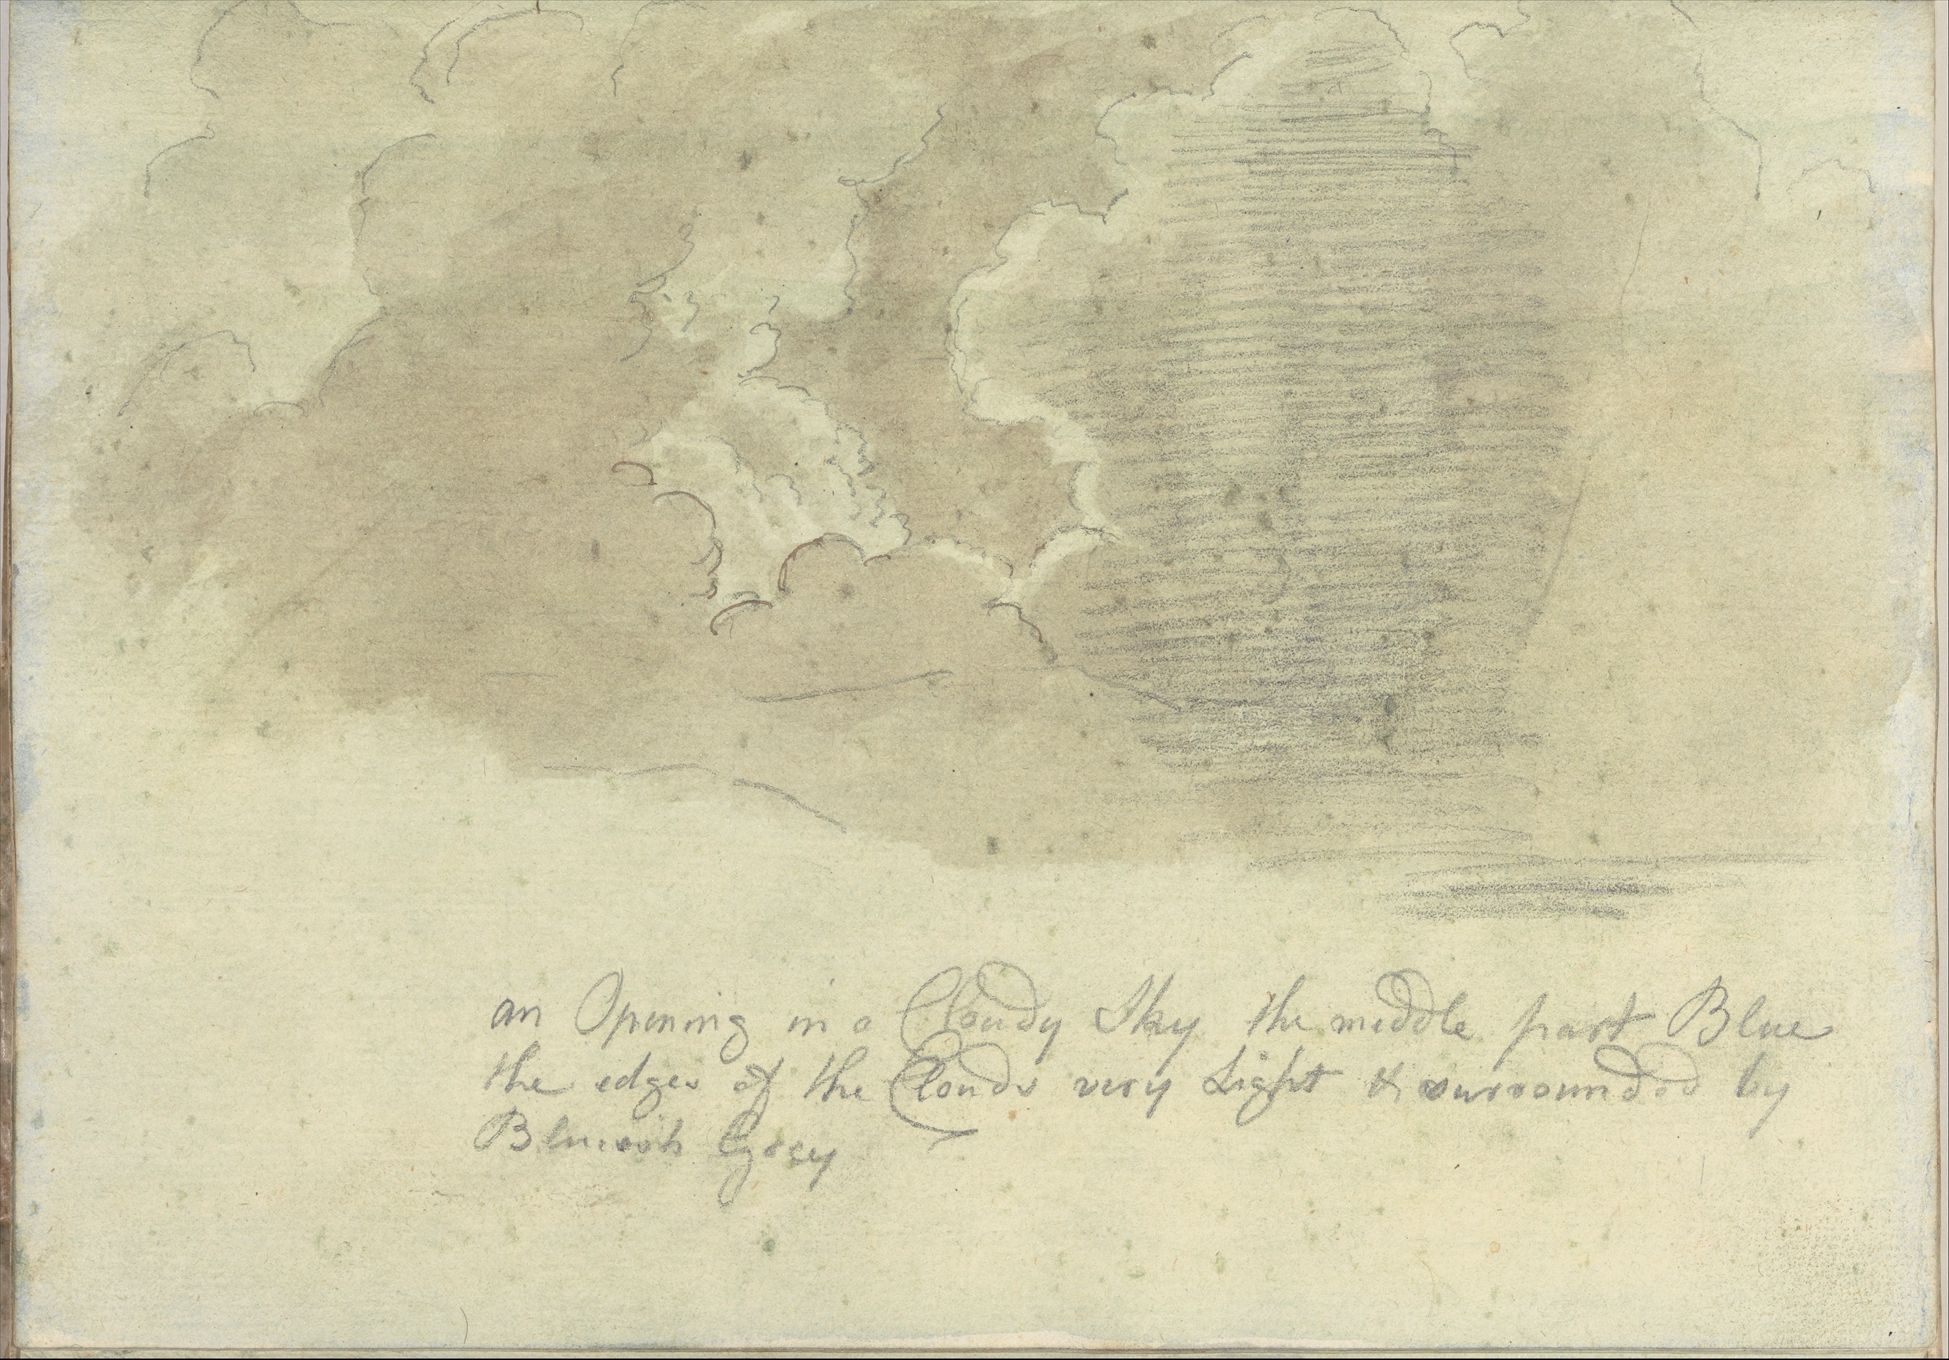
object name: drawing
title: An Opening in a Cloudy Sky (Smaller Italian sketchbook, leaf 13 recto)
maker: joseph wright (wright of derby)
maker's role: artist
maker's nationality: british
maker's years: 1734-1797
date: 1774-1775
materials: graphite, ink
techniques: brush, pen, wash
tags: clouds